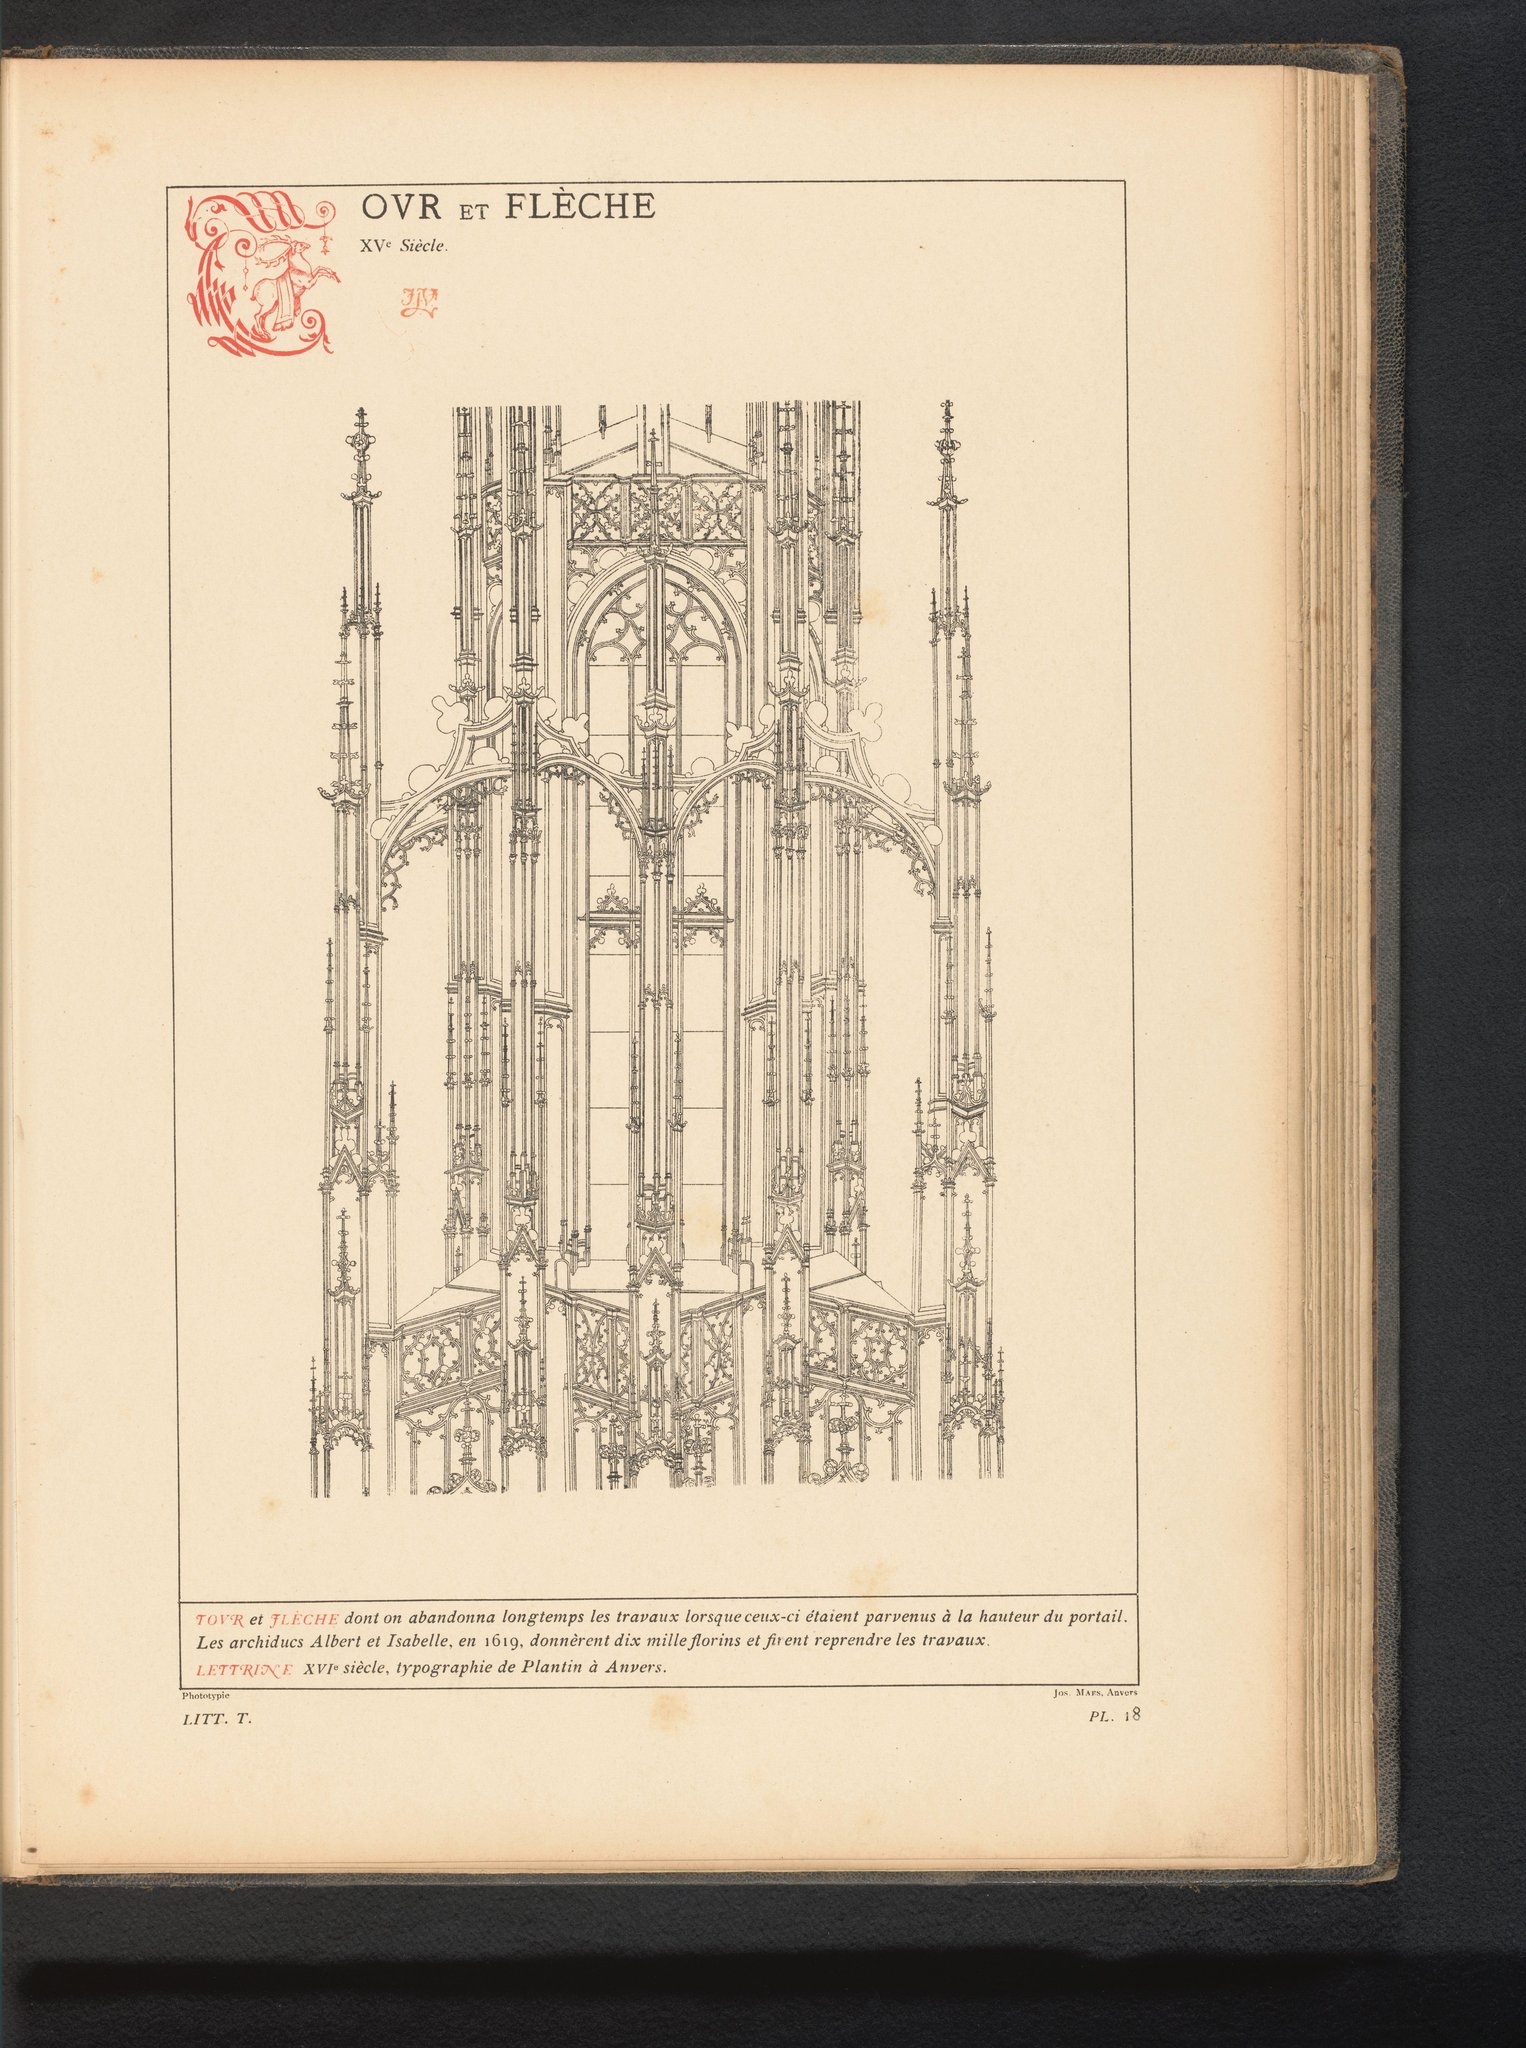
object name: reproduction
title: Reproductie van een prent van de ramen en torens van de Sint-Waltrudiskerk te Bergen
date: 1876-1881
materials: paper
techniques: photolithography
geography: antwerp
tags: church (exterior)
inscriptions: inscription: ‘TOUR et FLÈCHE (...)’, monogram: ‘JJvY’, inscription: ‘LITT. T. - PL. 18.’